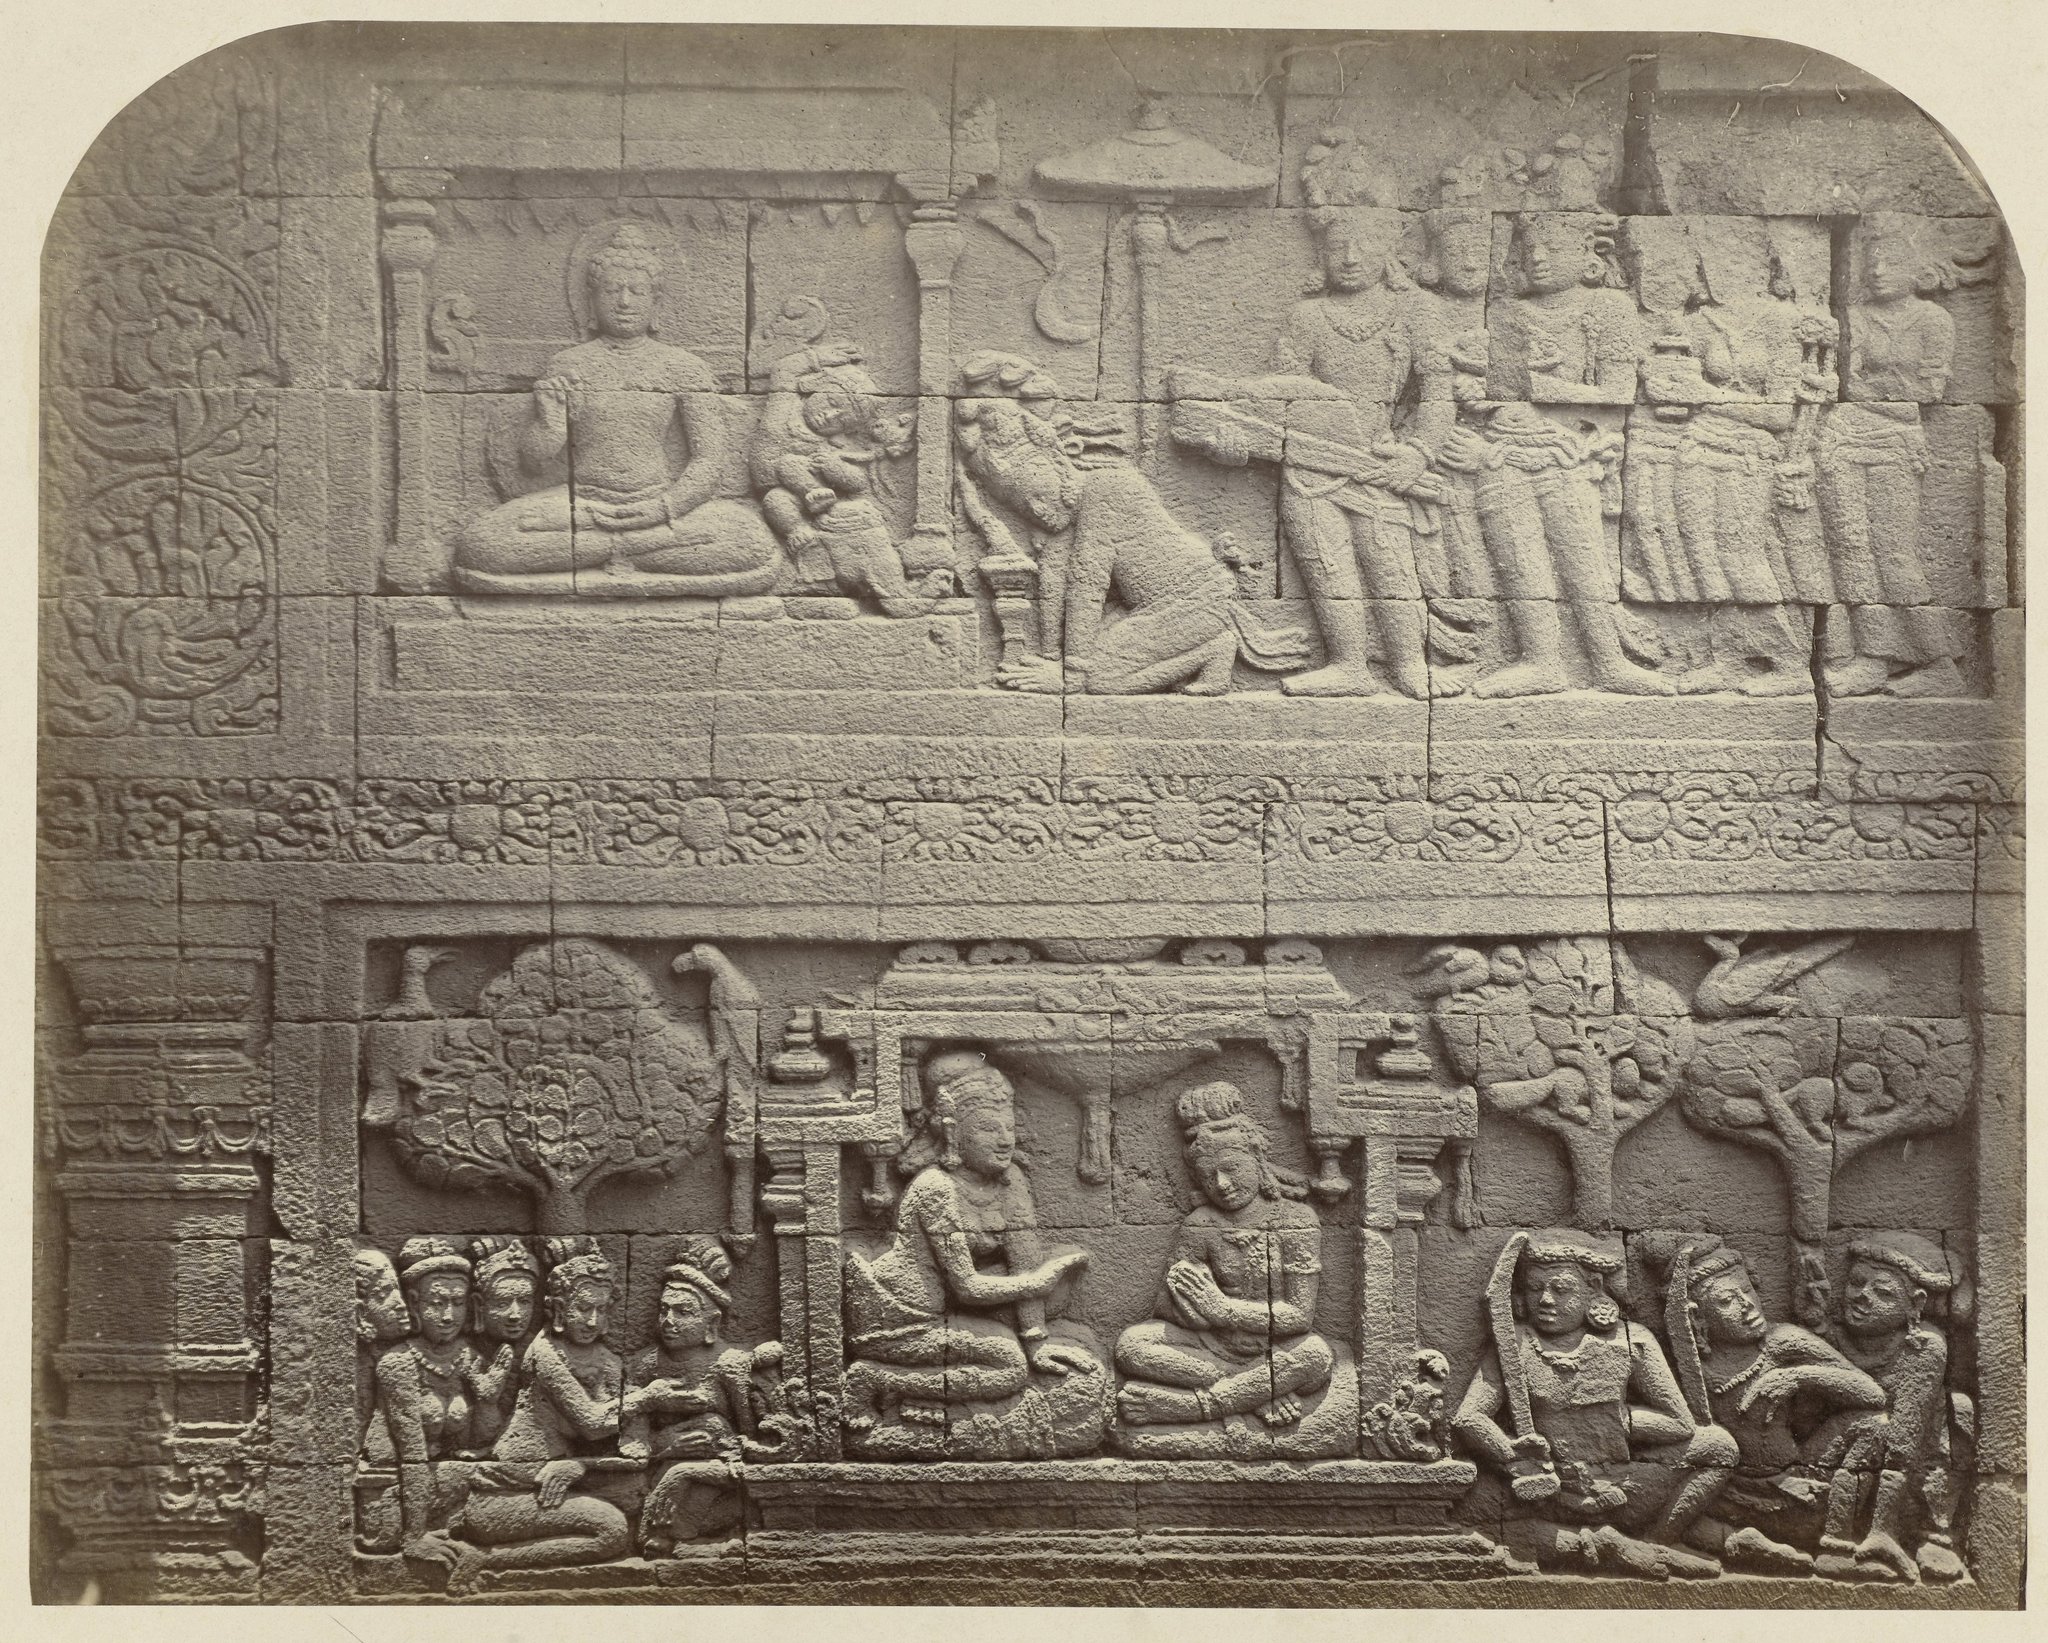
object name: photograph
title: Basreliëf in de noordzijde van de Borobudur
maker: isidore kinsbergen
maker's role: fotograaf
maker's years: 1821-1905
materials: cardboard, paper, photographic support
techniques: albumen print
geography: java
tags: borobudur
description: Gallery I, main wall, north side 55 (top): Relief 1a-101, Lalitavistara relief, the naga king Mucilinda honouring the Buddha. 56 (bottom): relief 1b-101, unidentified scene, two people in a heavenly pavilion. Borobudur village, Magelang district, Central Java province, 778-824 AD.